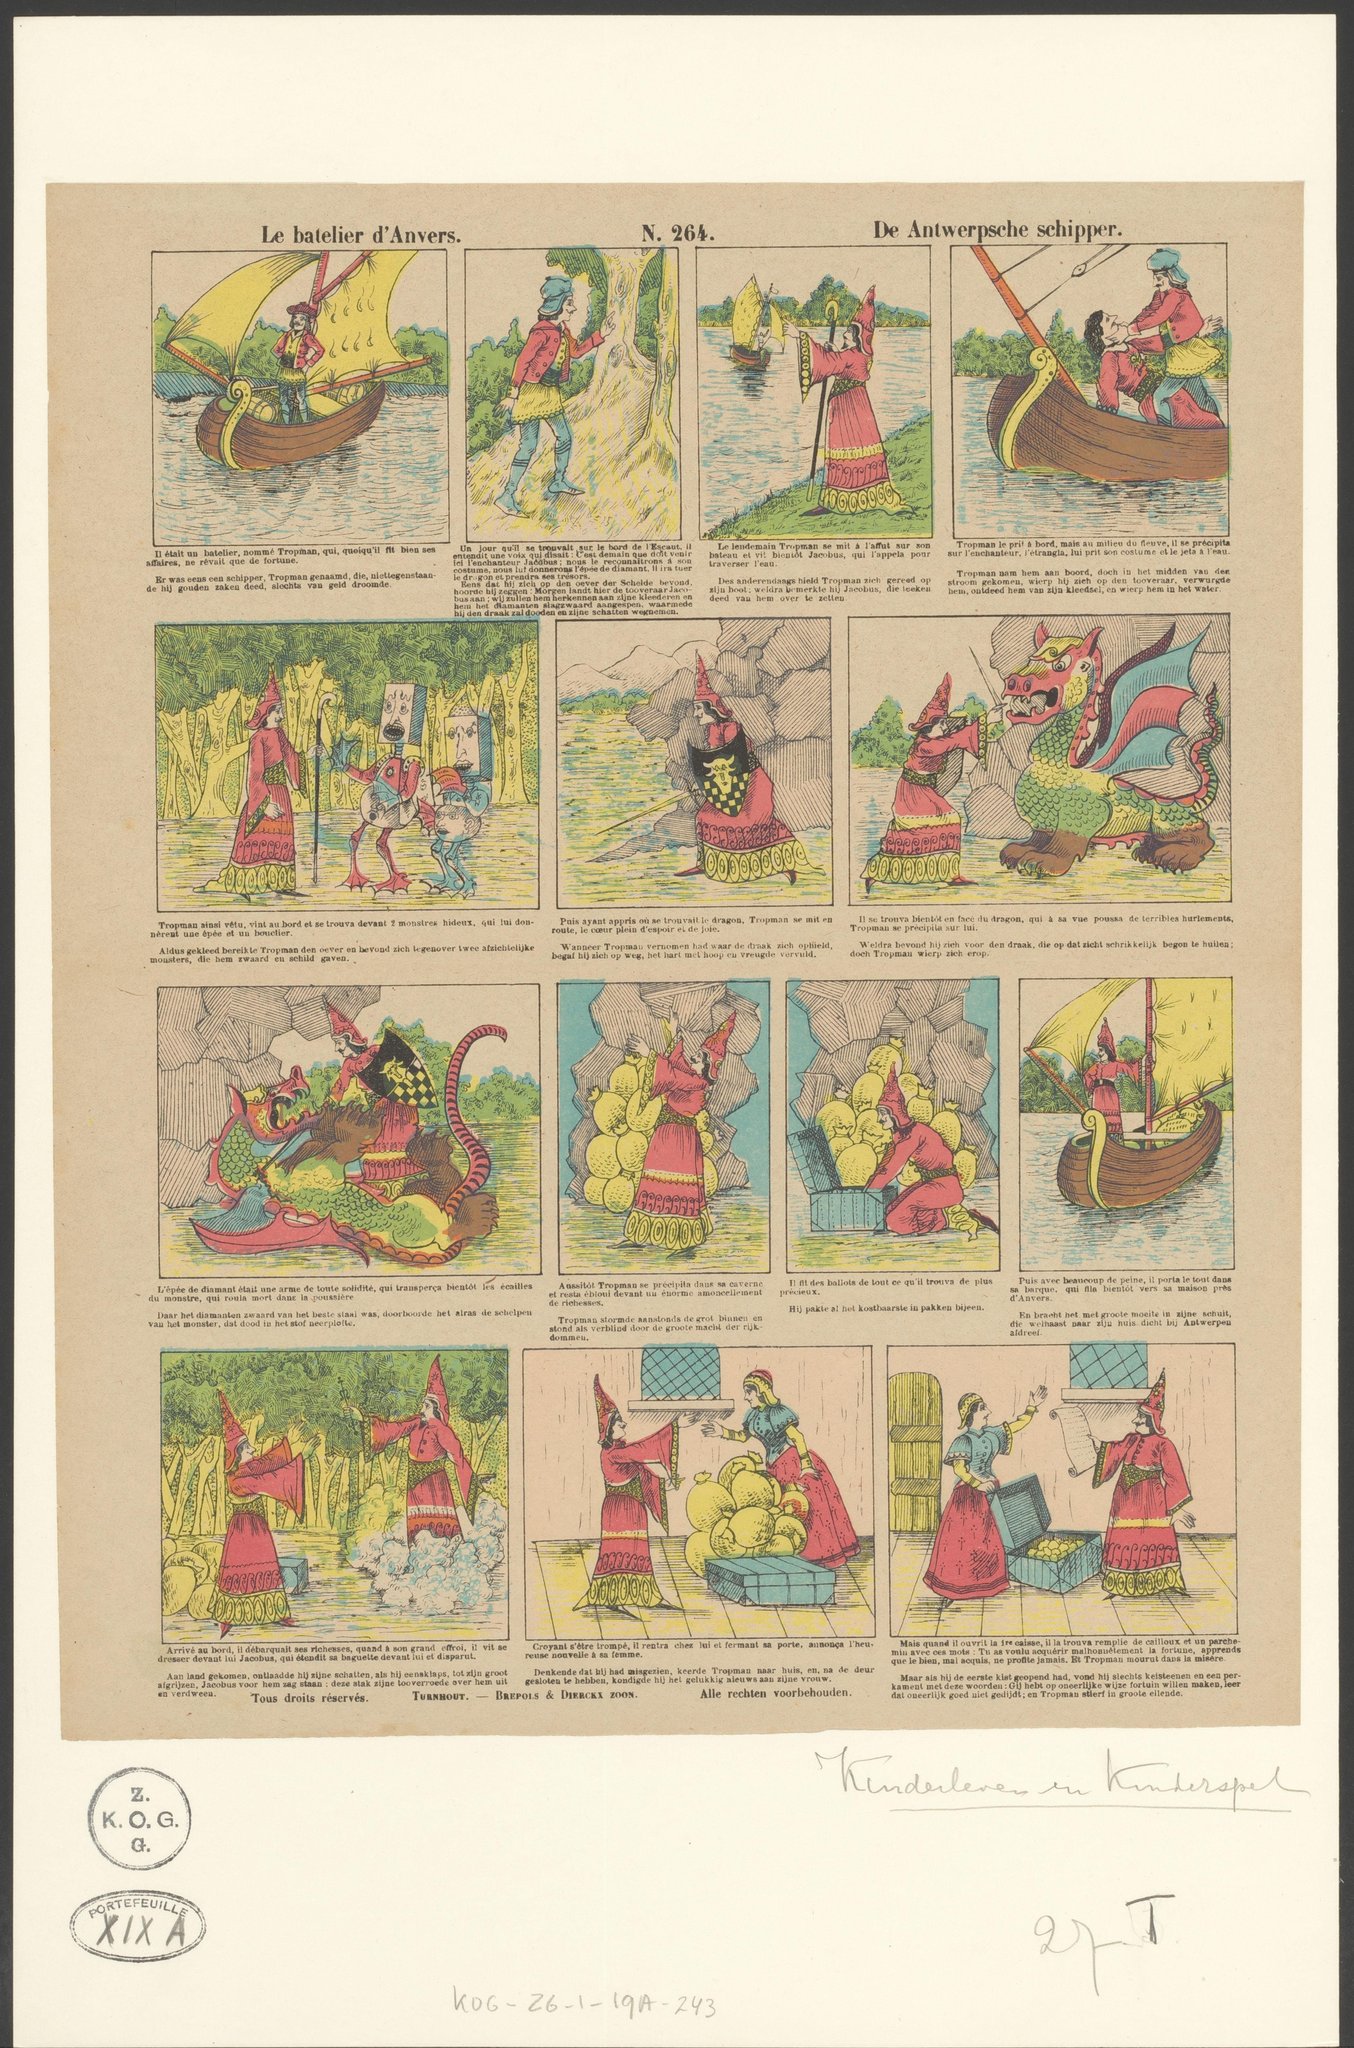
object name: print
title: Le batelier d'Anvers / De Antwerpsche schipper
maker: Anonymous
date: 1833-1935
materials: paper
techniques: lithograph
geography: turnhout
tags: sailing-ship, sailing-boat, sorcerer, magician, wizard, warlock, dragon, antwerp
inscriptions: stamp, : ‘Tous droits réservés’, collector's mark: Lugt 1641, : ‘Alle rechten voorbehouden’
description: Blad met veertien voorstellingen uit het verhaal over de Antwerpse schipper. Onder elke afbeelding een onderschrift in het Nederlands en in het Frans. Genummerd midden boven: N. 264. Onderwerpsrubrieken binnen de Atlas Zeden en Gewoonten: Zeden en Gewoonten in Engeren Zin, Des menschen beging, midden en einde, Kinderleven – Kinderspel en Kinderprenten.